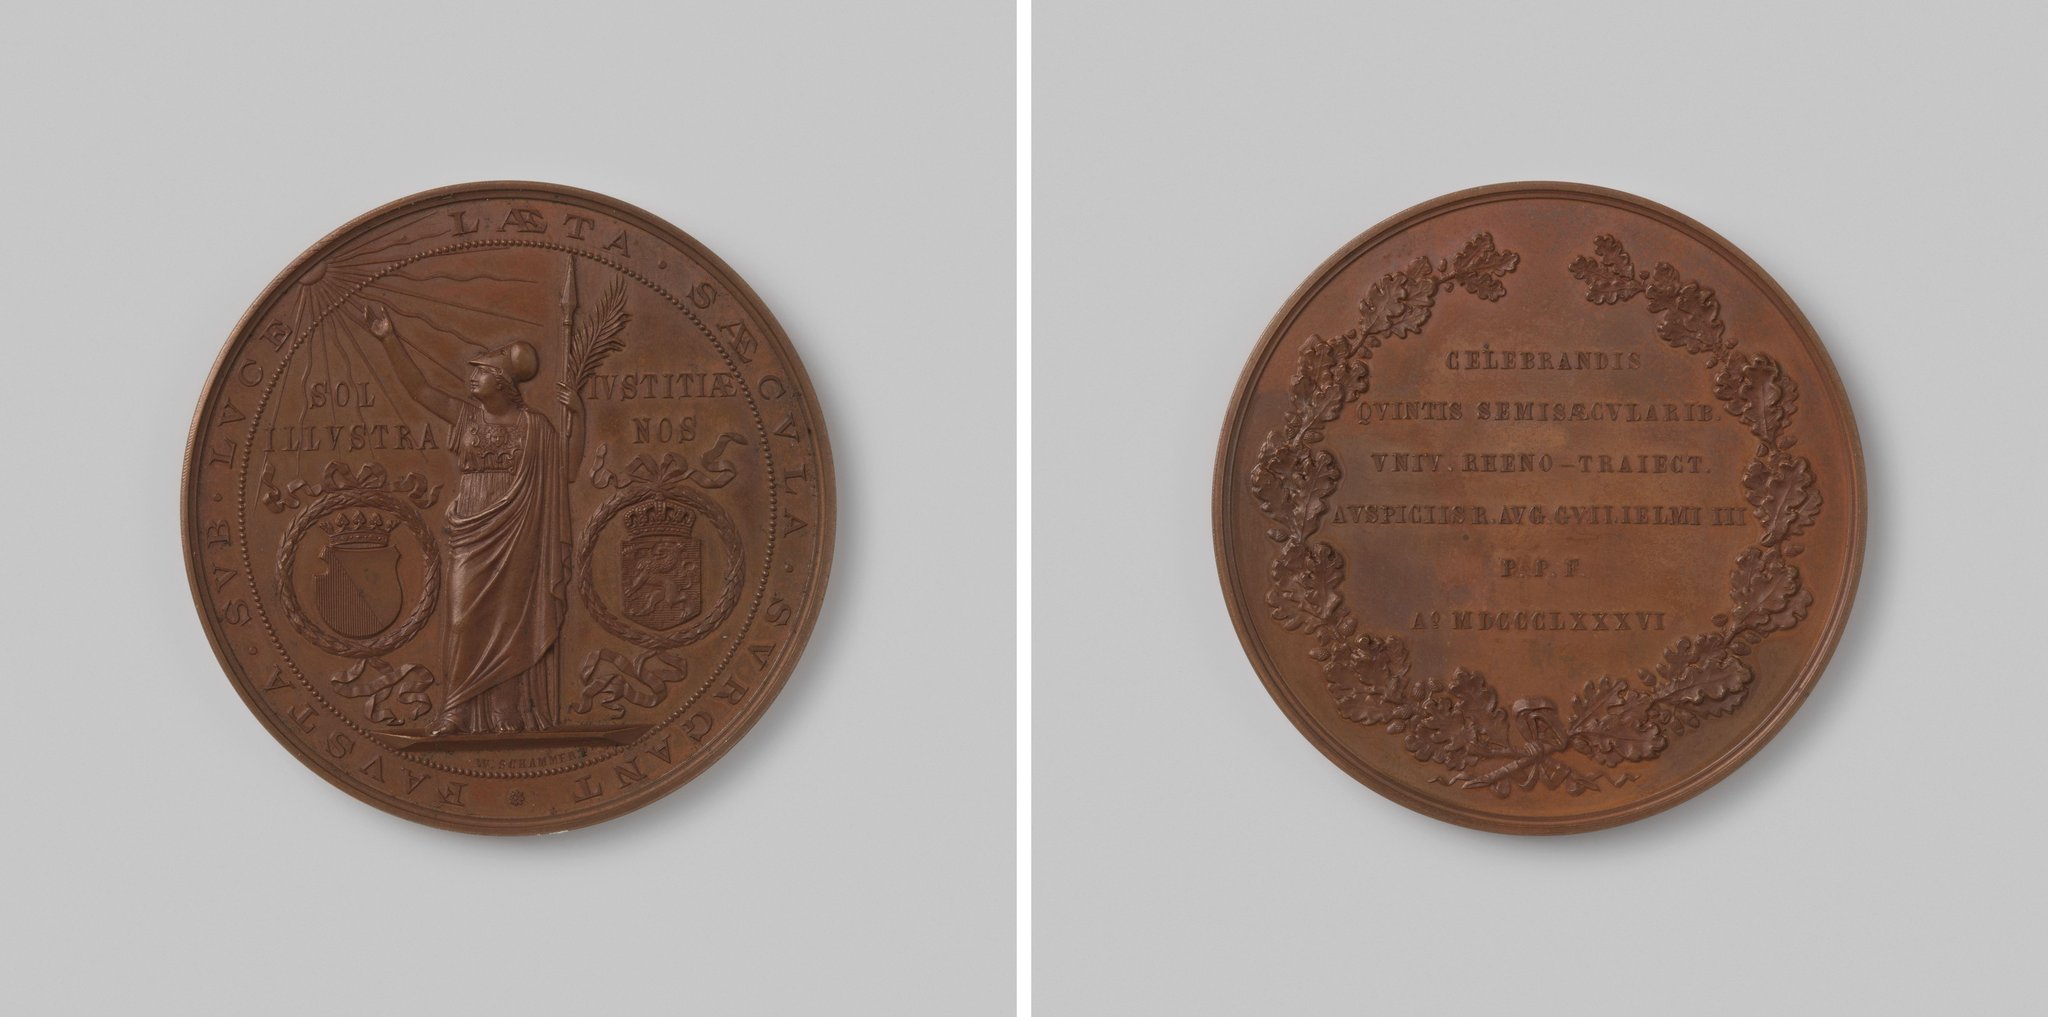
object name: history medal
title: Tweehonderdvijftigjarig bestaan van de Universiteit van Utrecht 1886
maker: willem schammer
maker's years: 1814-1853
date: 1886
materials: bronze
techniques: striking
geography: utrecht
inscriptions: factory mark: ‘mercuriusstaf’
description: Bronzen penning, op de voorzijde Minerva met lans en palmtak wijzend op de stralende zon, tussen de omkranste gekroonde wapenschilden van de stad Utrecht en Nederland, met tekst in het veld en omschrift, op de keerzijde zes regels tekst tussen samengestrikte eikentakken.